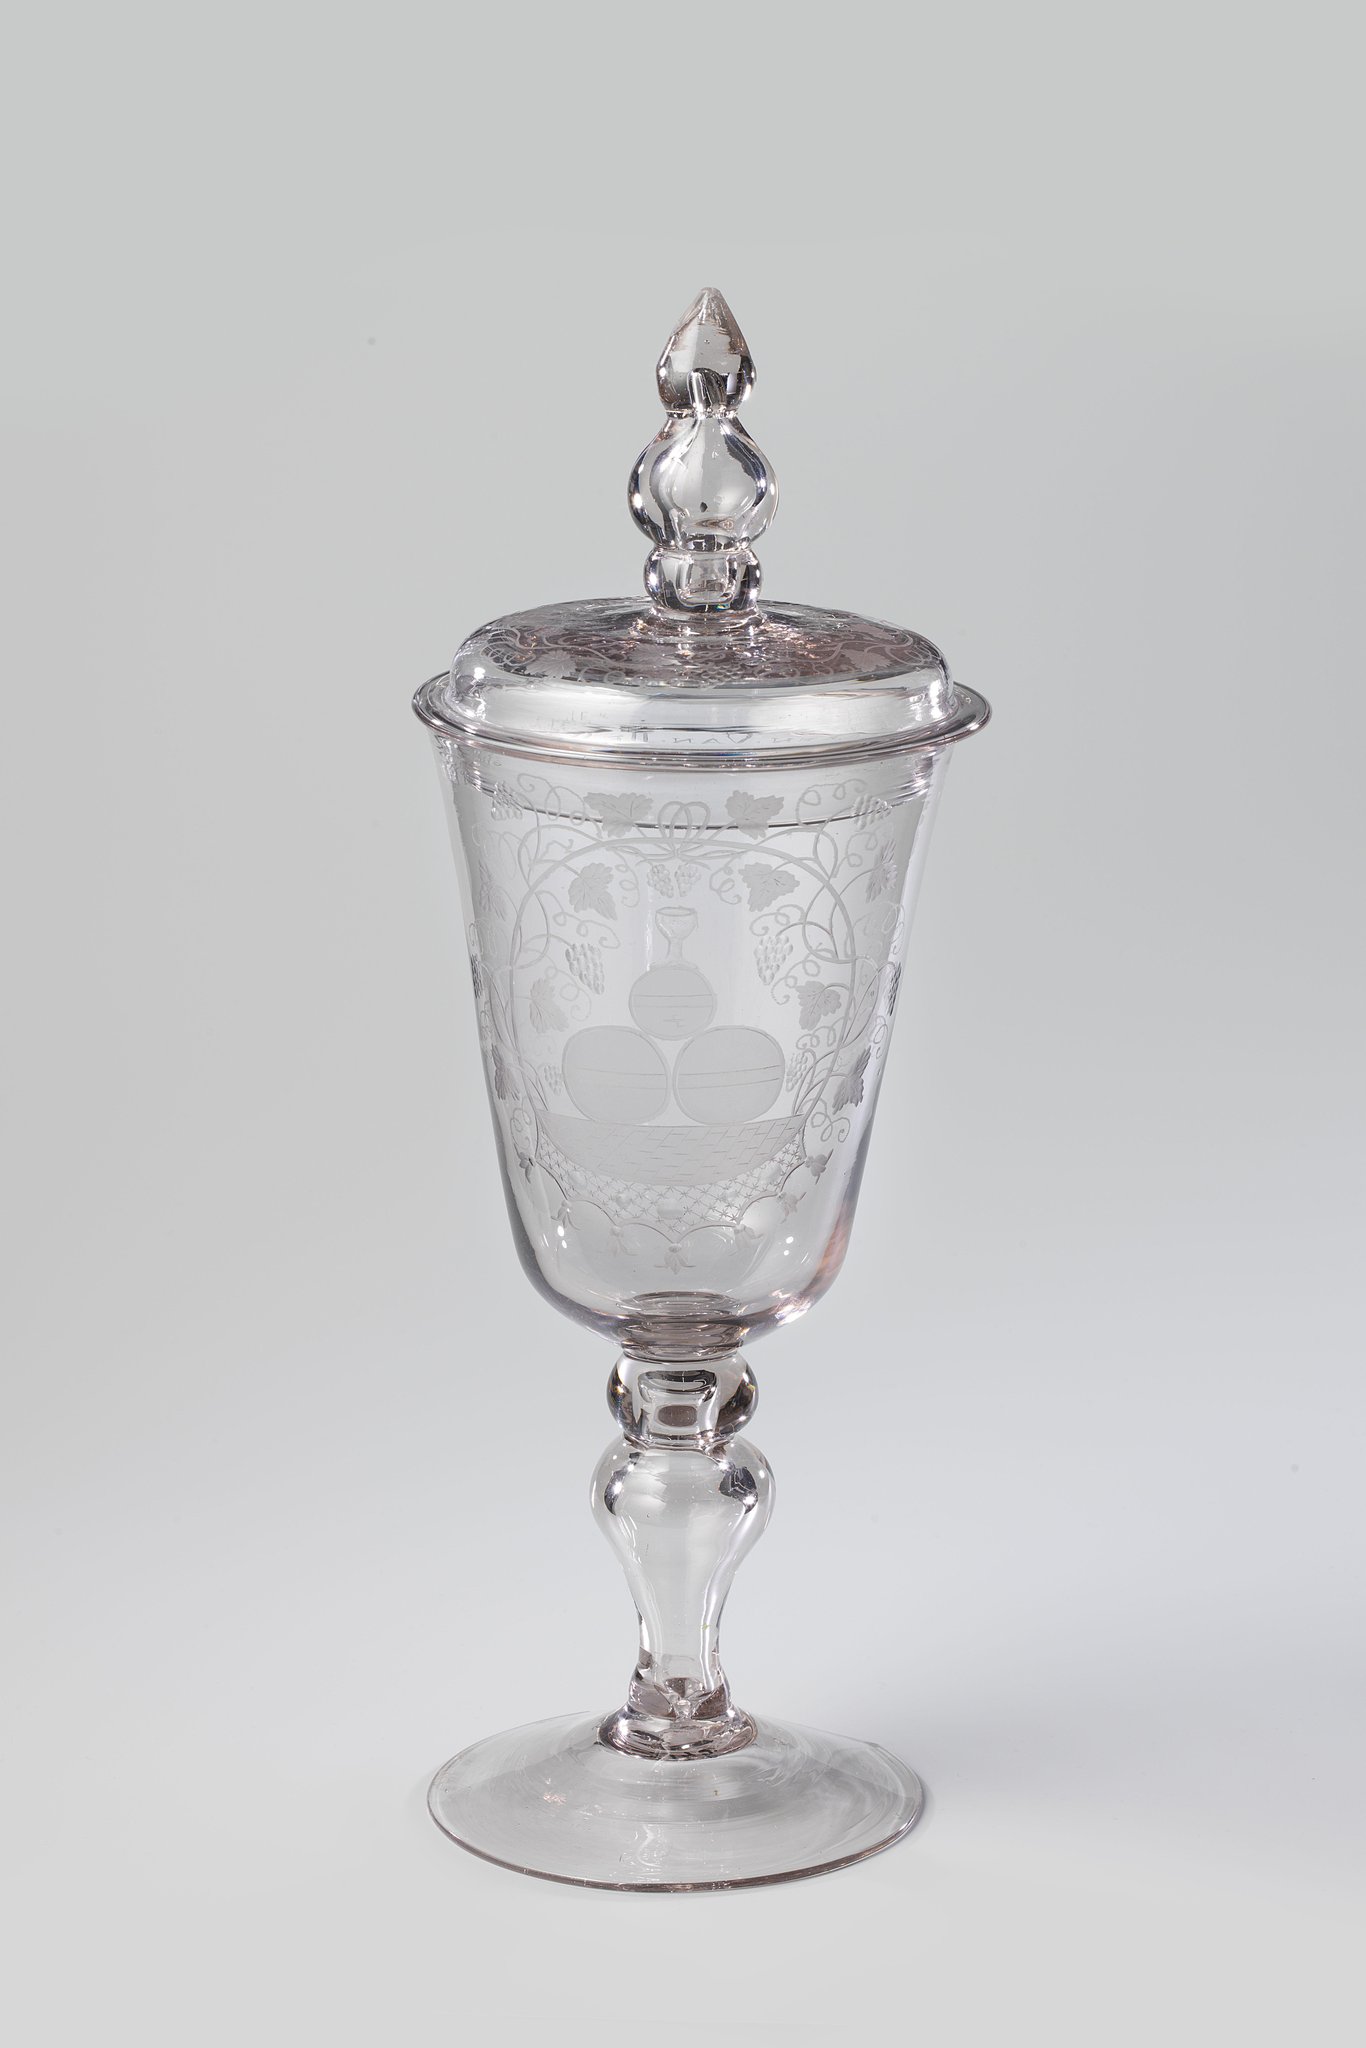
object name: goblet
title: Bokaal met deksel, met drie gestapelde wijnvaten en het opschrift: WELVAAREN.VAN.DE.WYN.COOPERY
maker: Anonymous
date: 1725-1750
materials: glass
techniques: glassblowing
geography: northern netherlands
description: Randschrift: WELVAAREN.VAN.DE.WYN.COOPERY. Ornamenten van druivenranken, rondom drie wijnvaten, waarop een kelk.